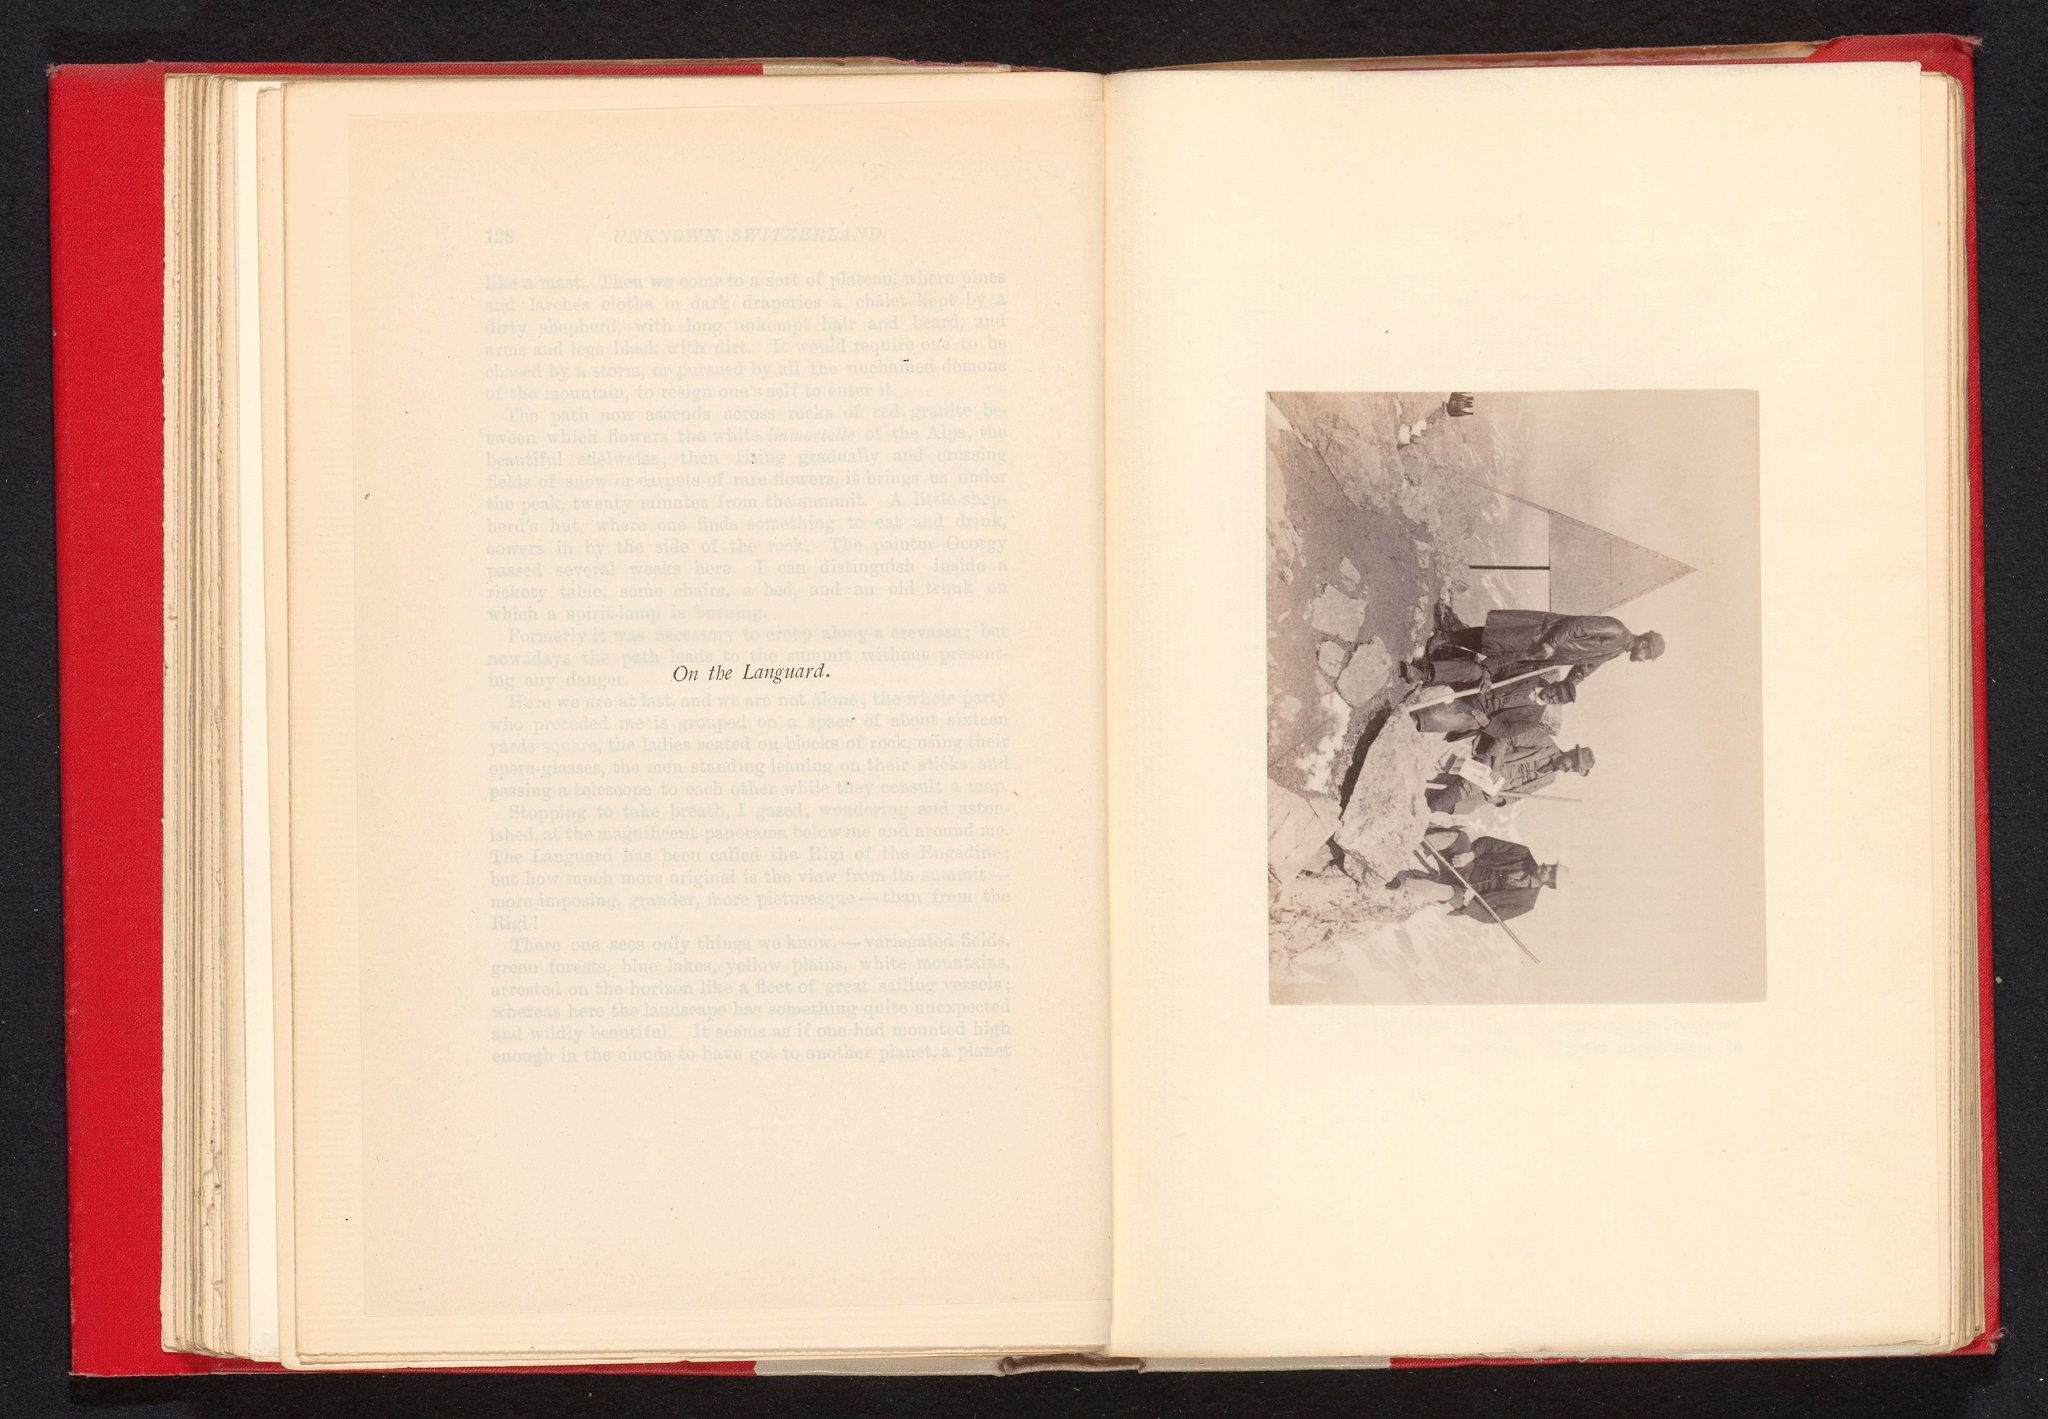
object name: photograph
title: On the Languard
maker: Anonymous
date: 1879-1889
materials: photographic support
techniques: albumen print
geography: graubunden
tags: mountain climbing, mountaineering, mountains